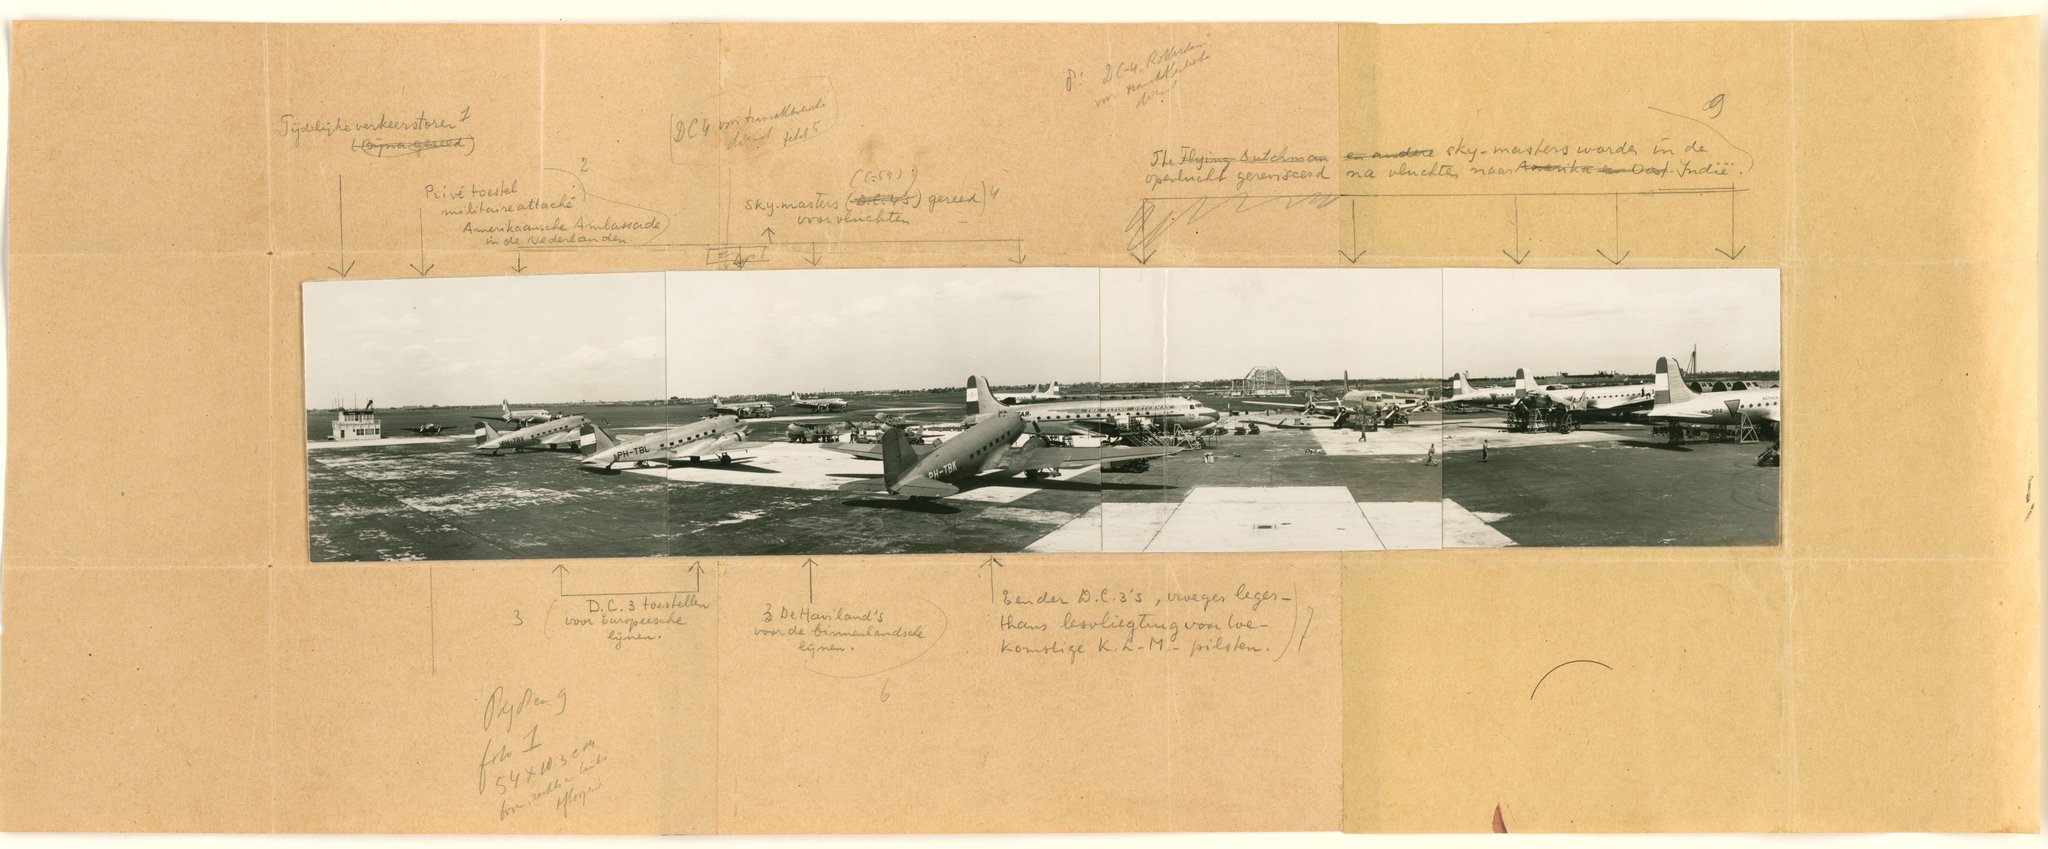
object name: documentary photograph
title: Schiphol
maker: Anonymous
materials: paper, photographic support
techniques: photography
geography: amsterdam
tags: amsterdam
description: Panoramafoto van de luchthaven Schiphol. Op de foto zijn diverse noodgebouwen te zien, zoals ket kantoor van de KLM, douanegebouw en hangars in aanbouw. Rechts staat de DC-4 Schiedam gereed voor vertrek naar New York met de bus die de passagiers naar het vliegtuig heeft gebracht. Pal daarachter het terras voor de wegbrengers. Onder en boven de foto staan met potlood diverse details beschreven over de vliegtuigen, gebouwen en de vluchten. De foto bestaat uit drie delen, is geplakt op beige papier. Over de foto ligt vloeipapier.